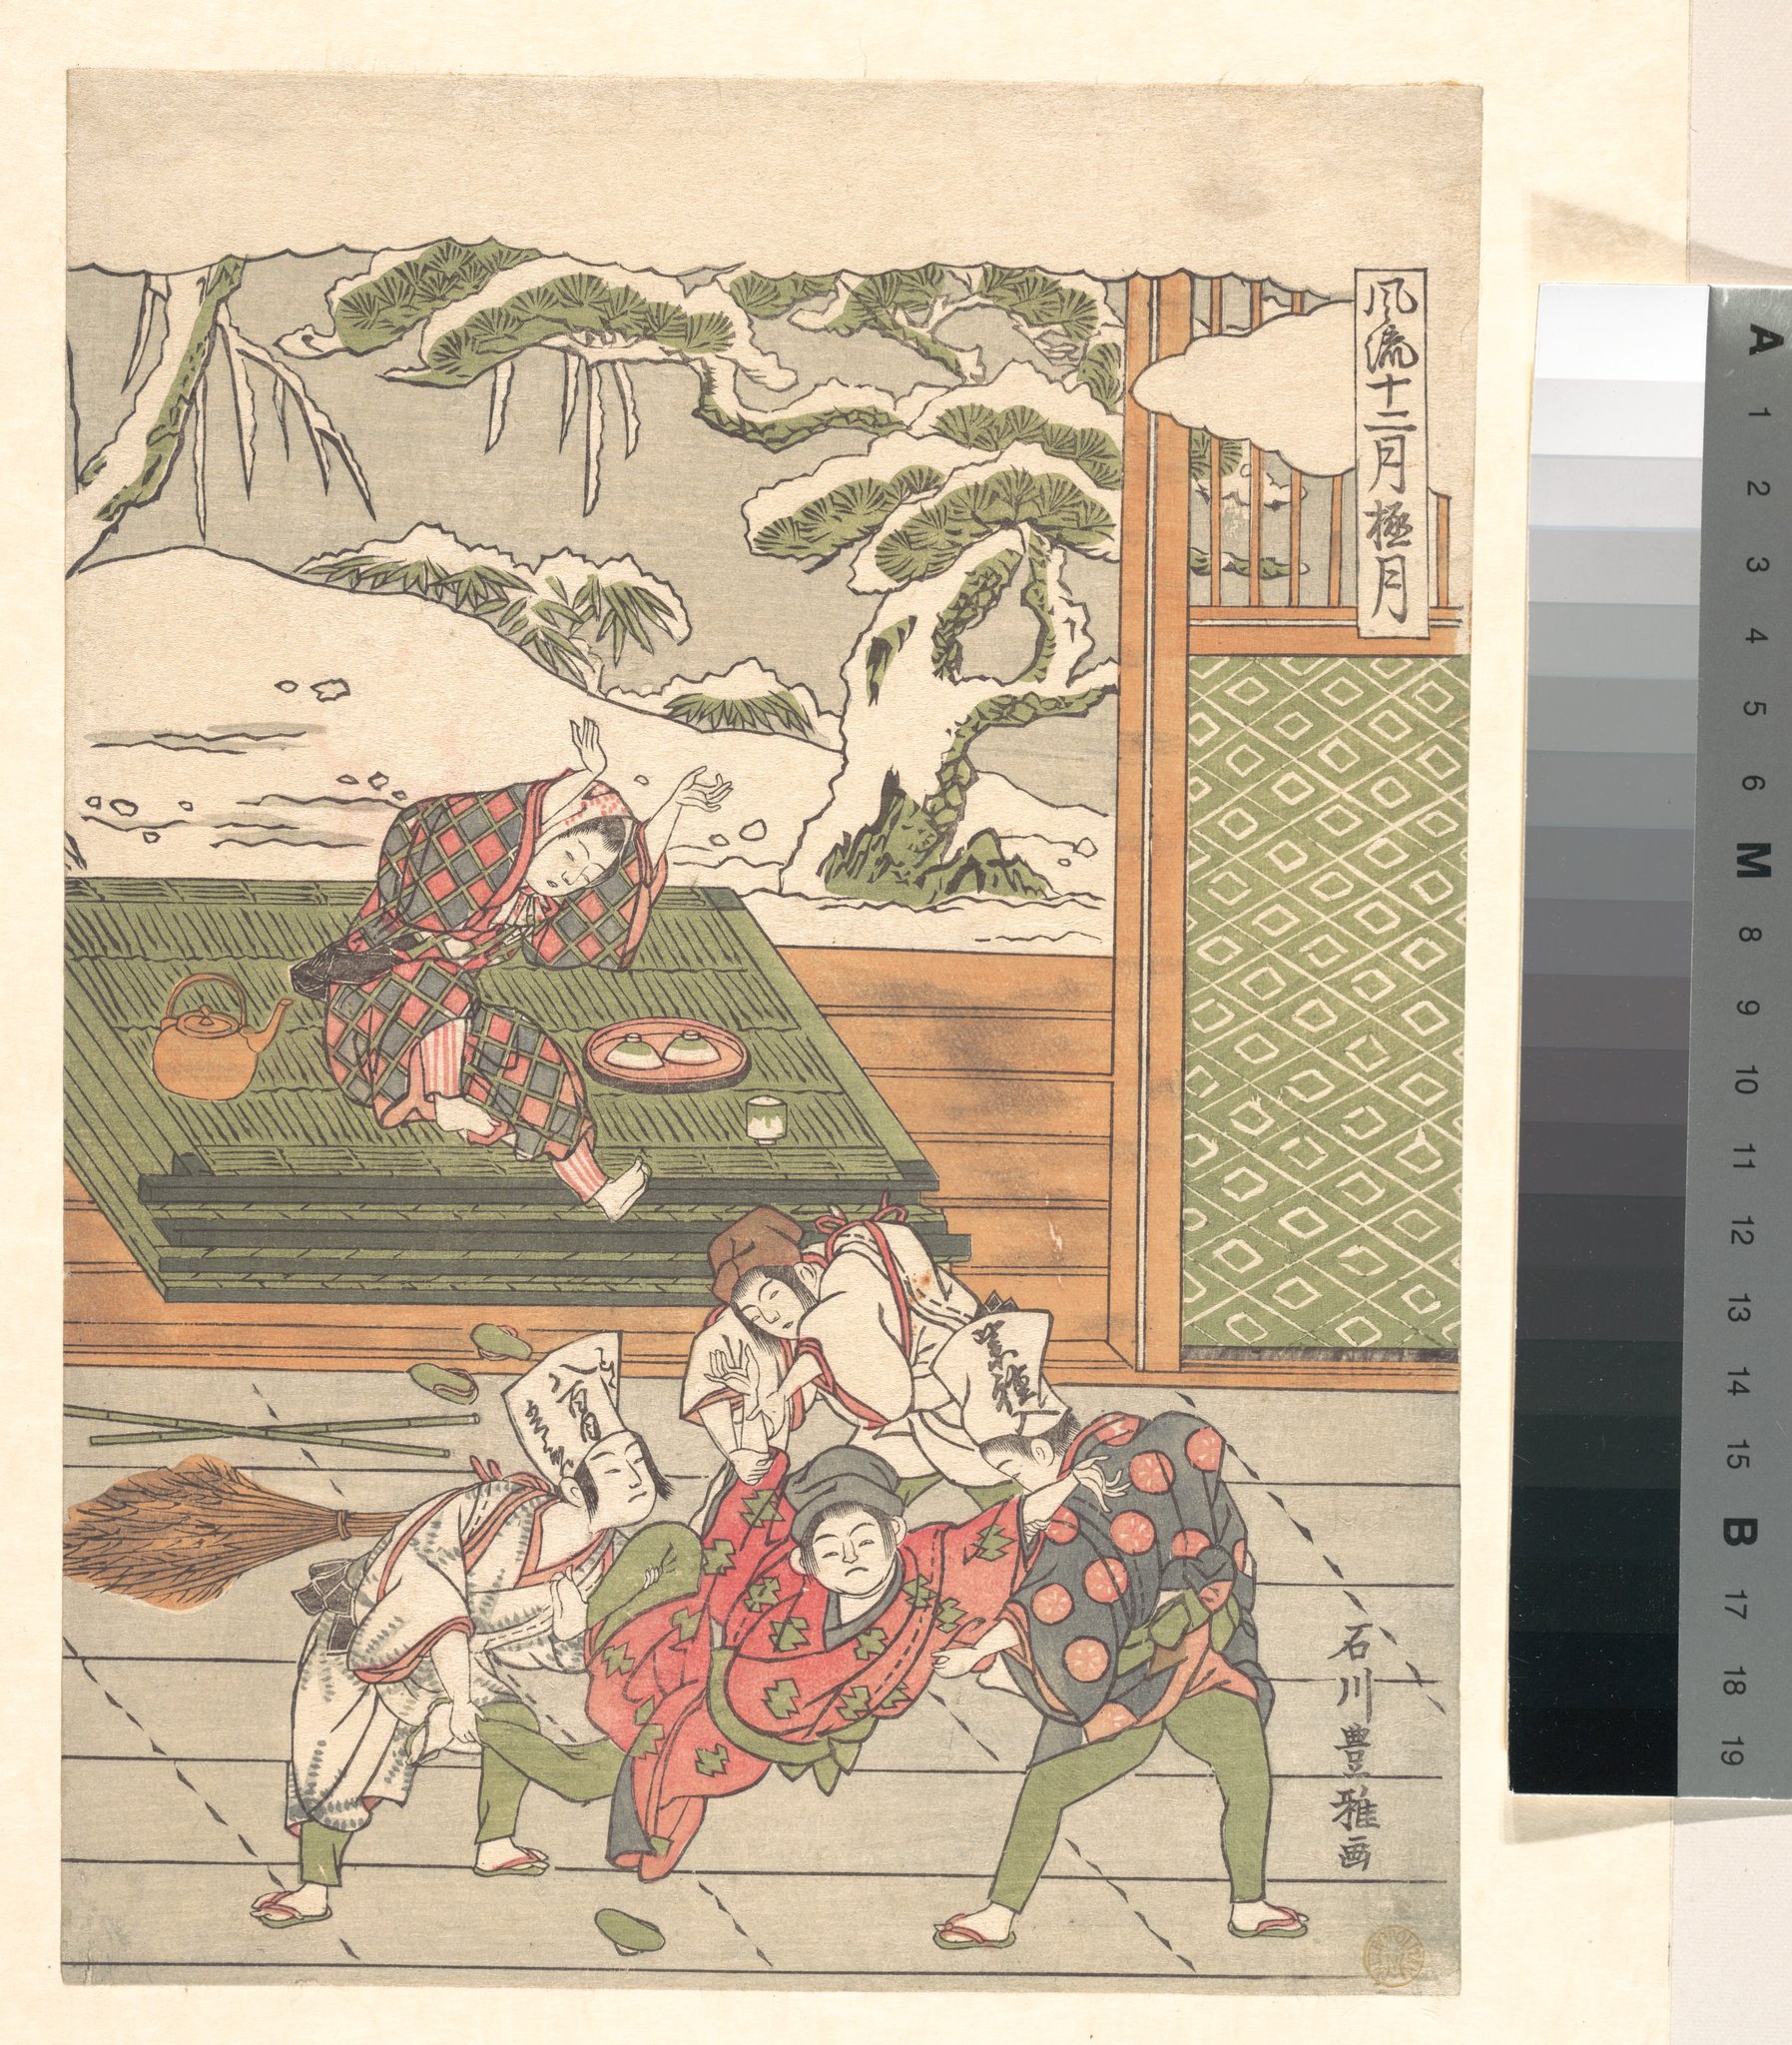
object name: print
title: The Twelfth Month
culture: japanese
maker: ishikawa toyomasa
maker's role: artist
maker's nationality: japanese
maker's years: 1770-1790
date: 1767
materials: ink, paper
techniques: woodblock print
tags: men,women,trees,snow